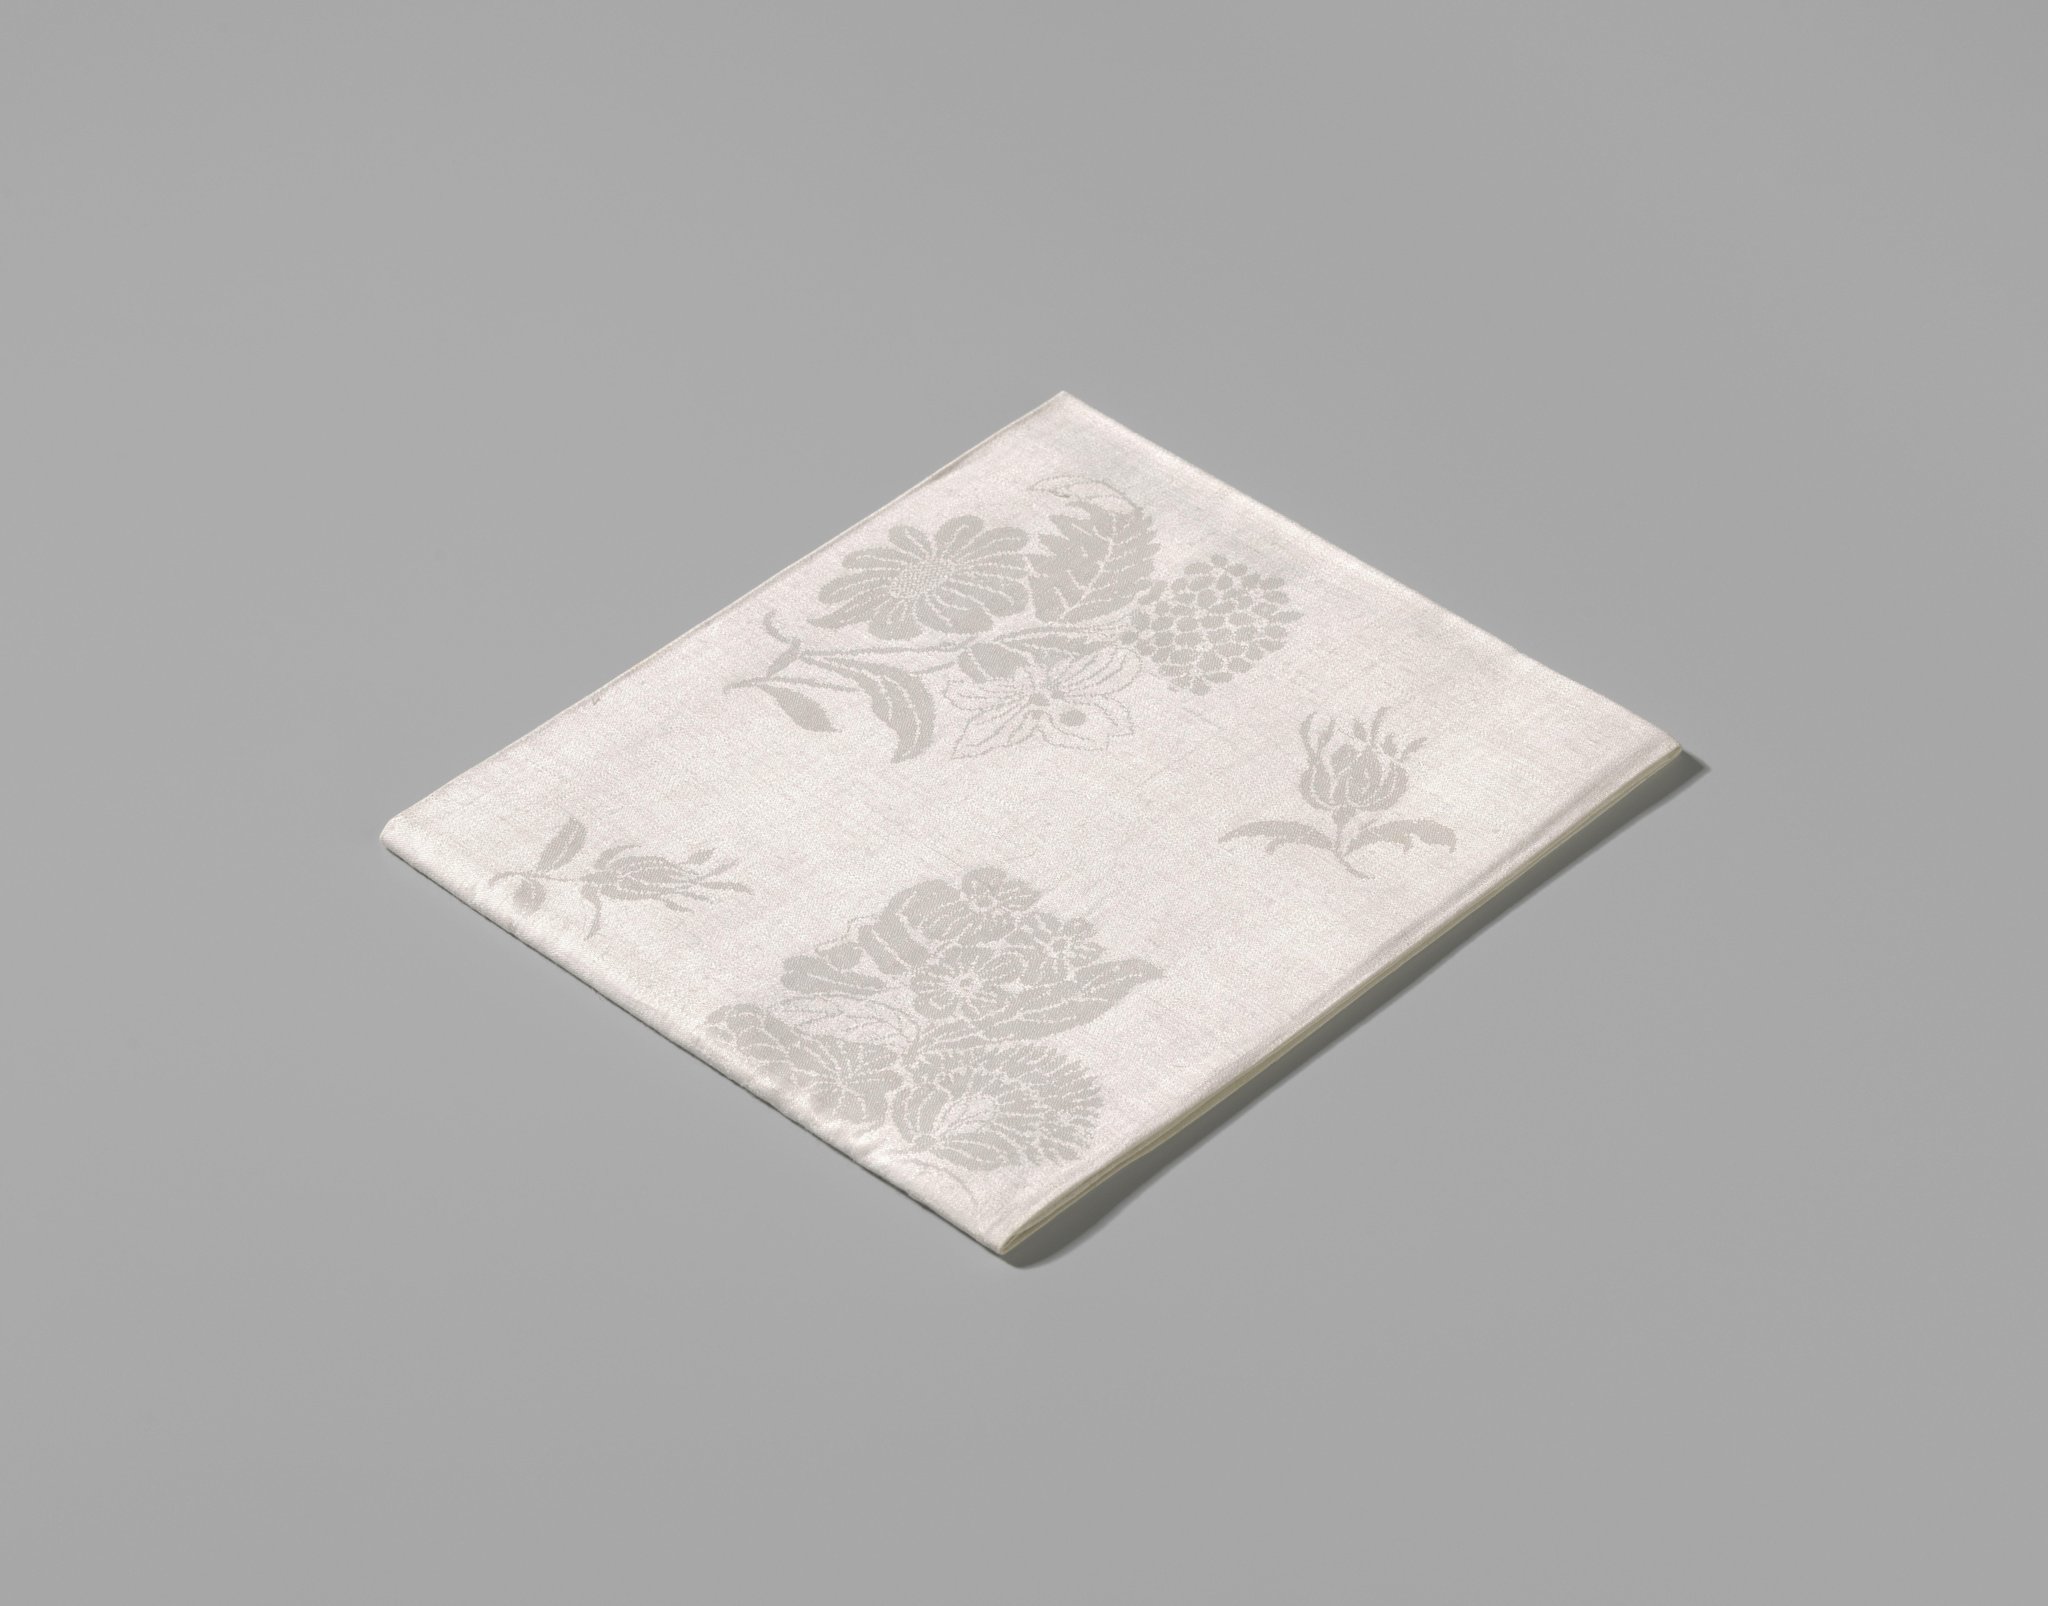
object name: napkin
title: Servet van wit linnendamast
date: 1831-1850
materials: linen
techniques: damask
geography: northern netherlands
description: Wit linnen damasten servet met bloemtakken en bloemenrand. Merk HW 12